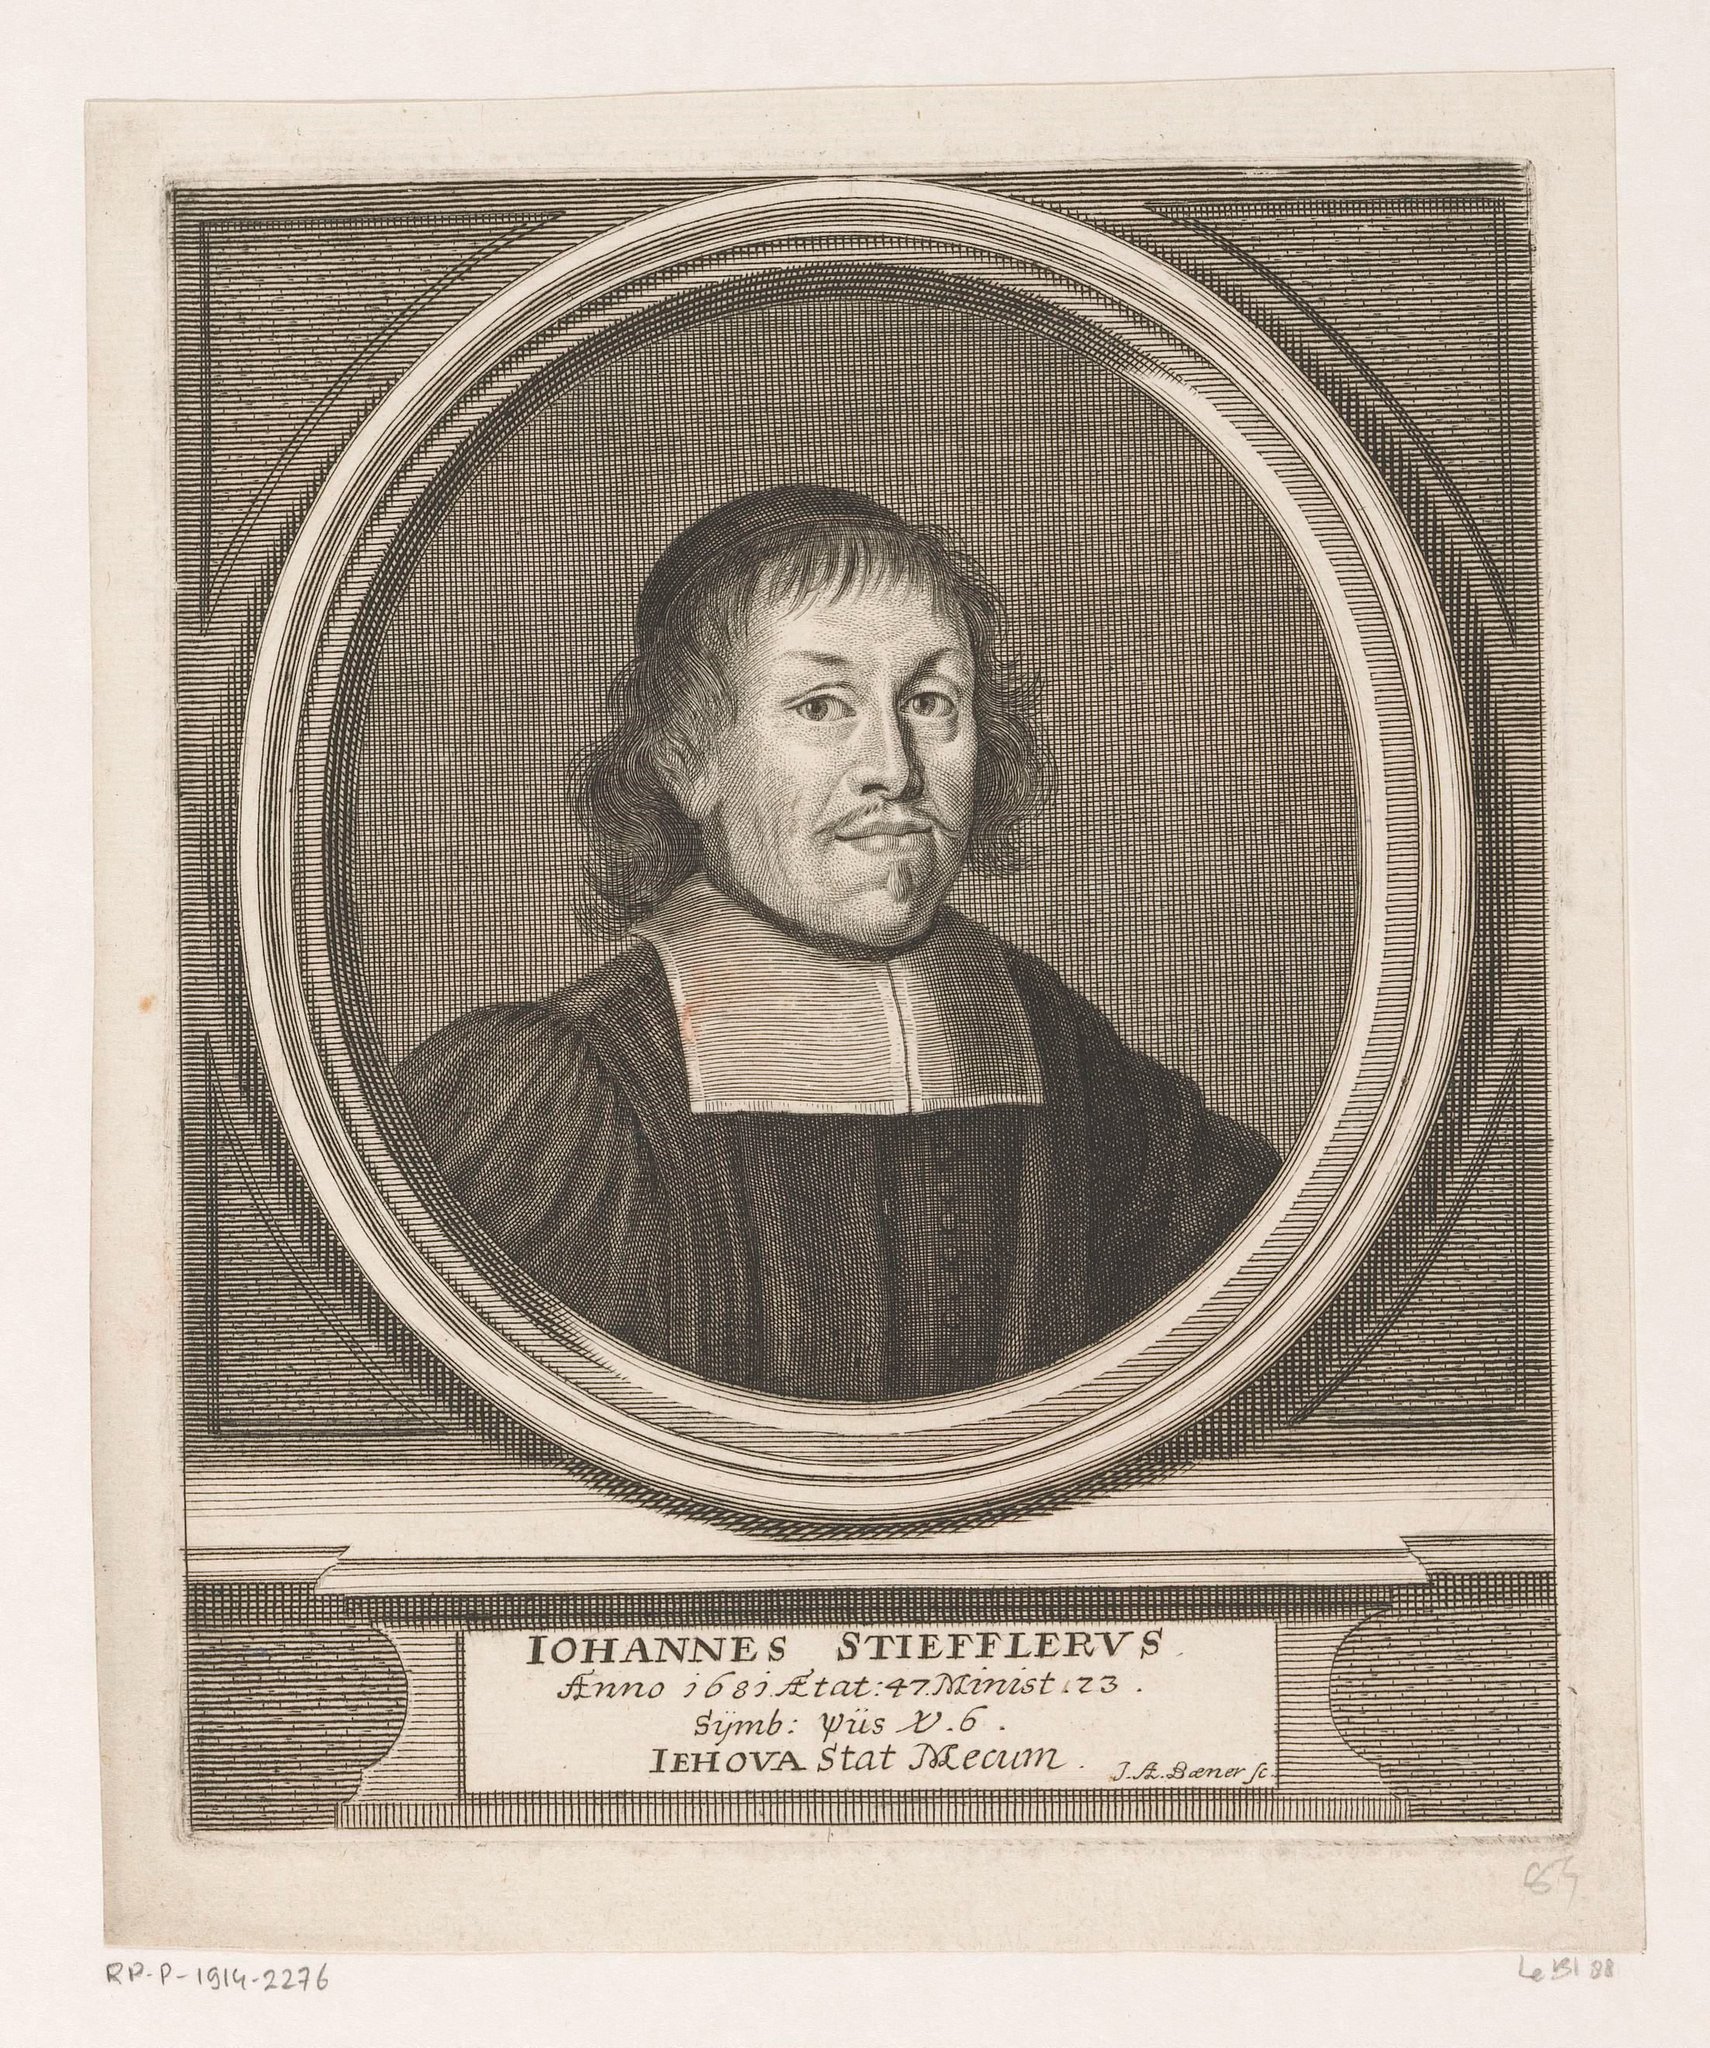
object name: print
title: Portret van Johann Stieffler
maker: johann alexander böner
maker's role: draughtsman, print maker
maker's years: 1647-1720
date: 1681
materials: paper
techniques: engraving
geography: nuremberg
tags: historical persons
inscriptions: collector's mark: Lugt 2228